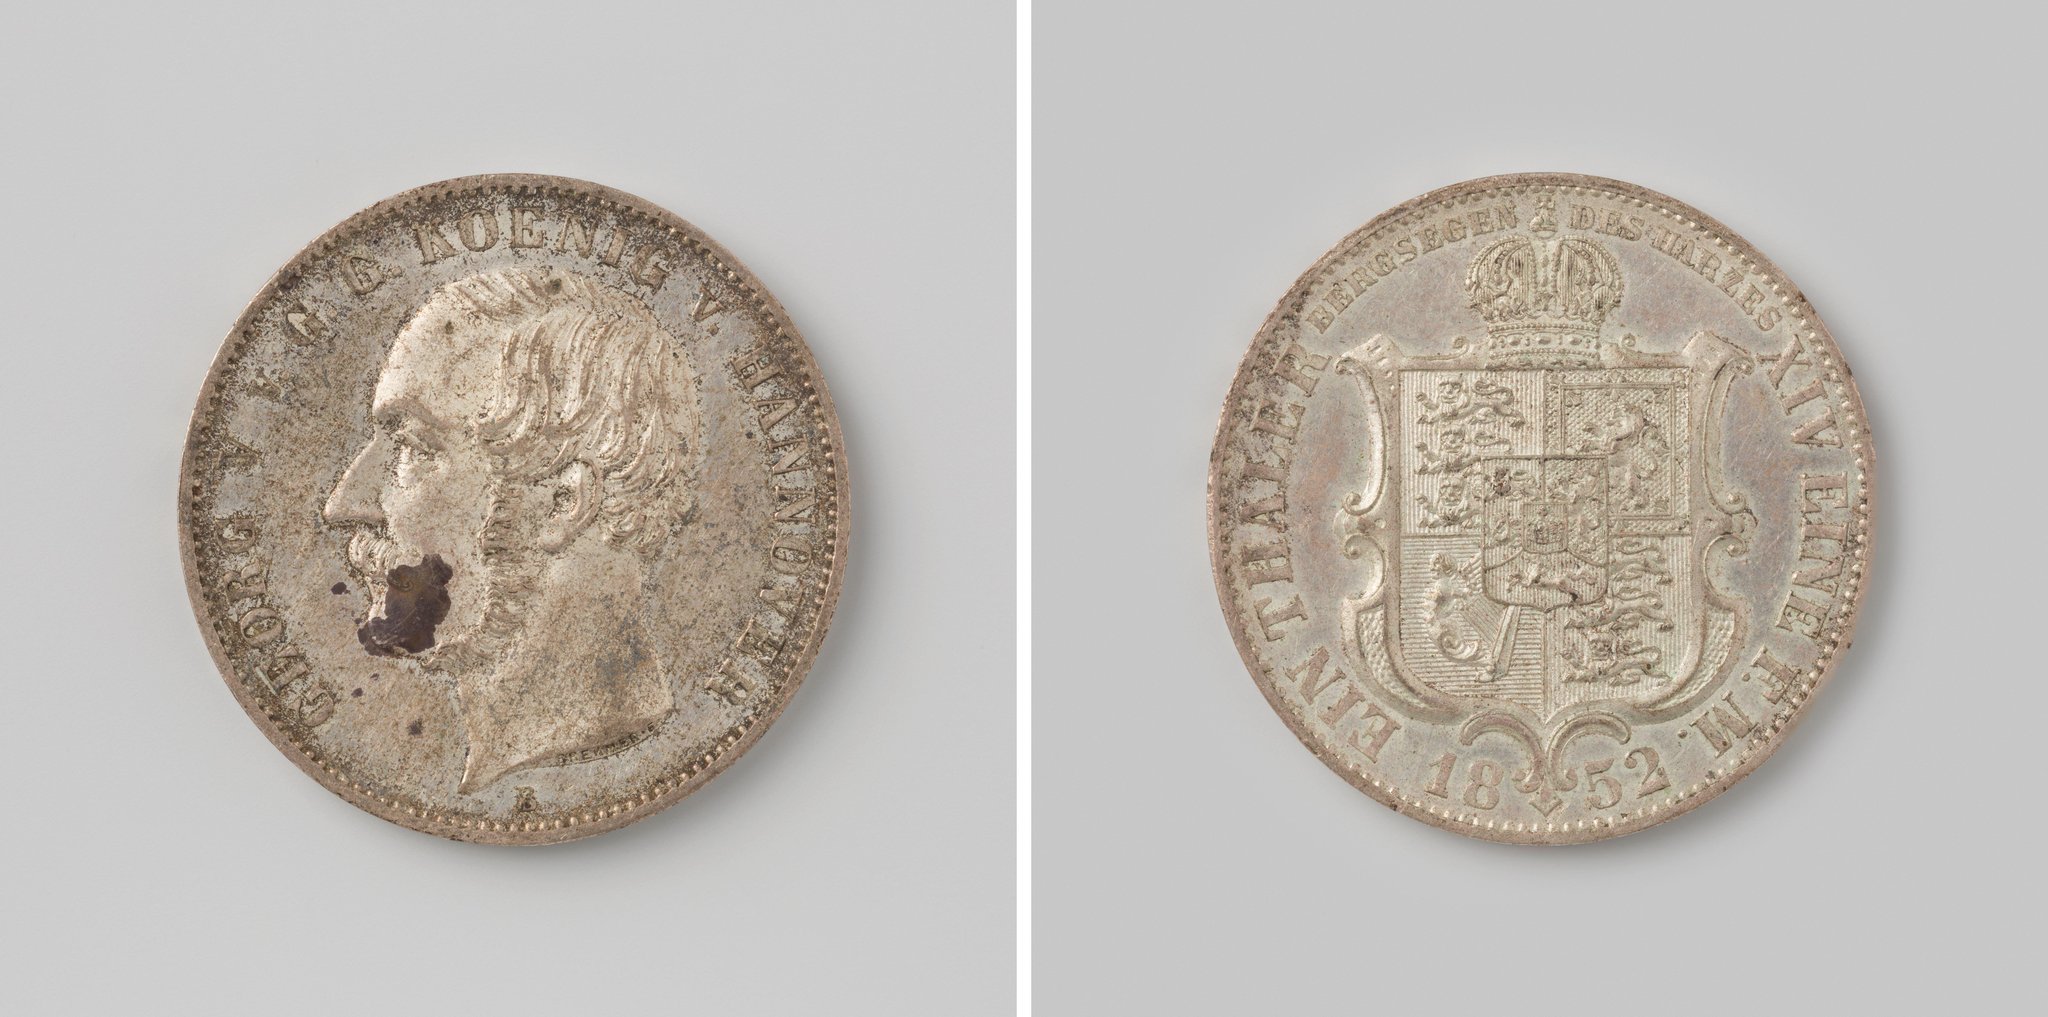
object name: taler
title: Taler uit het koninkrijk Hannover van Georg V, 1852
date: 1852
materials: silver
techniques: striking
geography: hannover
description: Zilveren munt. Voorzijde: hoofd van de koning naar links. Daaronder letter B. Keerzijde: gekroond versierd samengesteld wapenschild. Waarde-aanduiding in omschrift met onderaan jaartal. Randschrift.